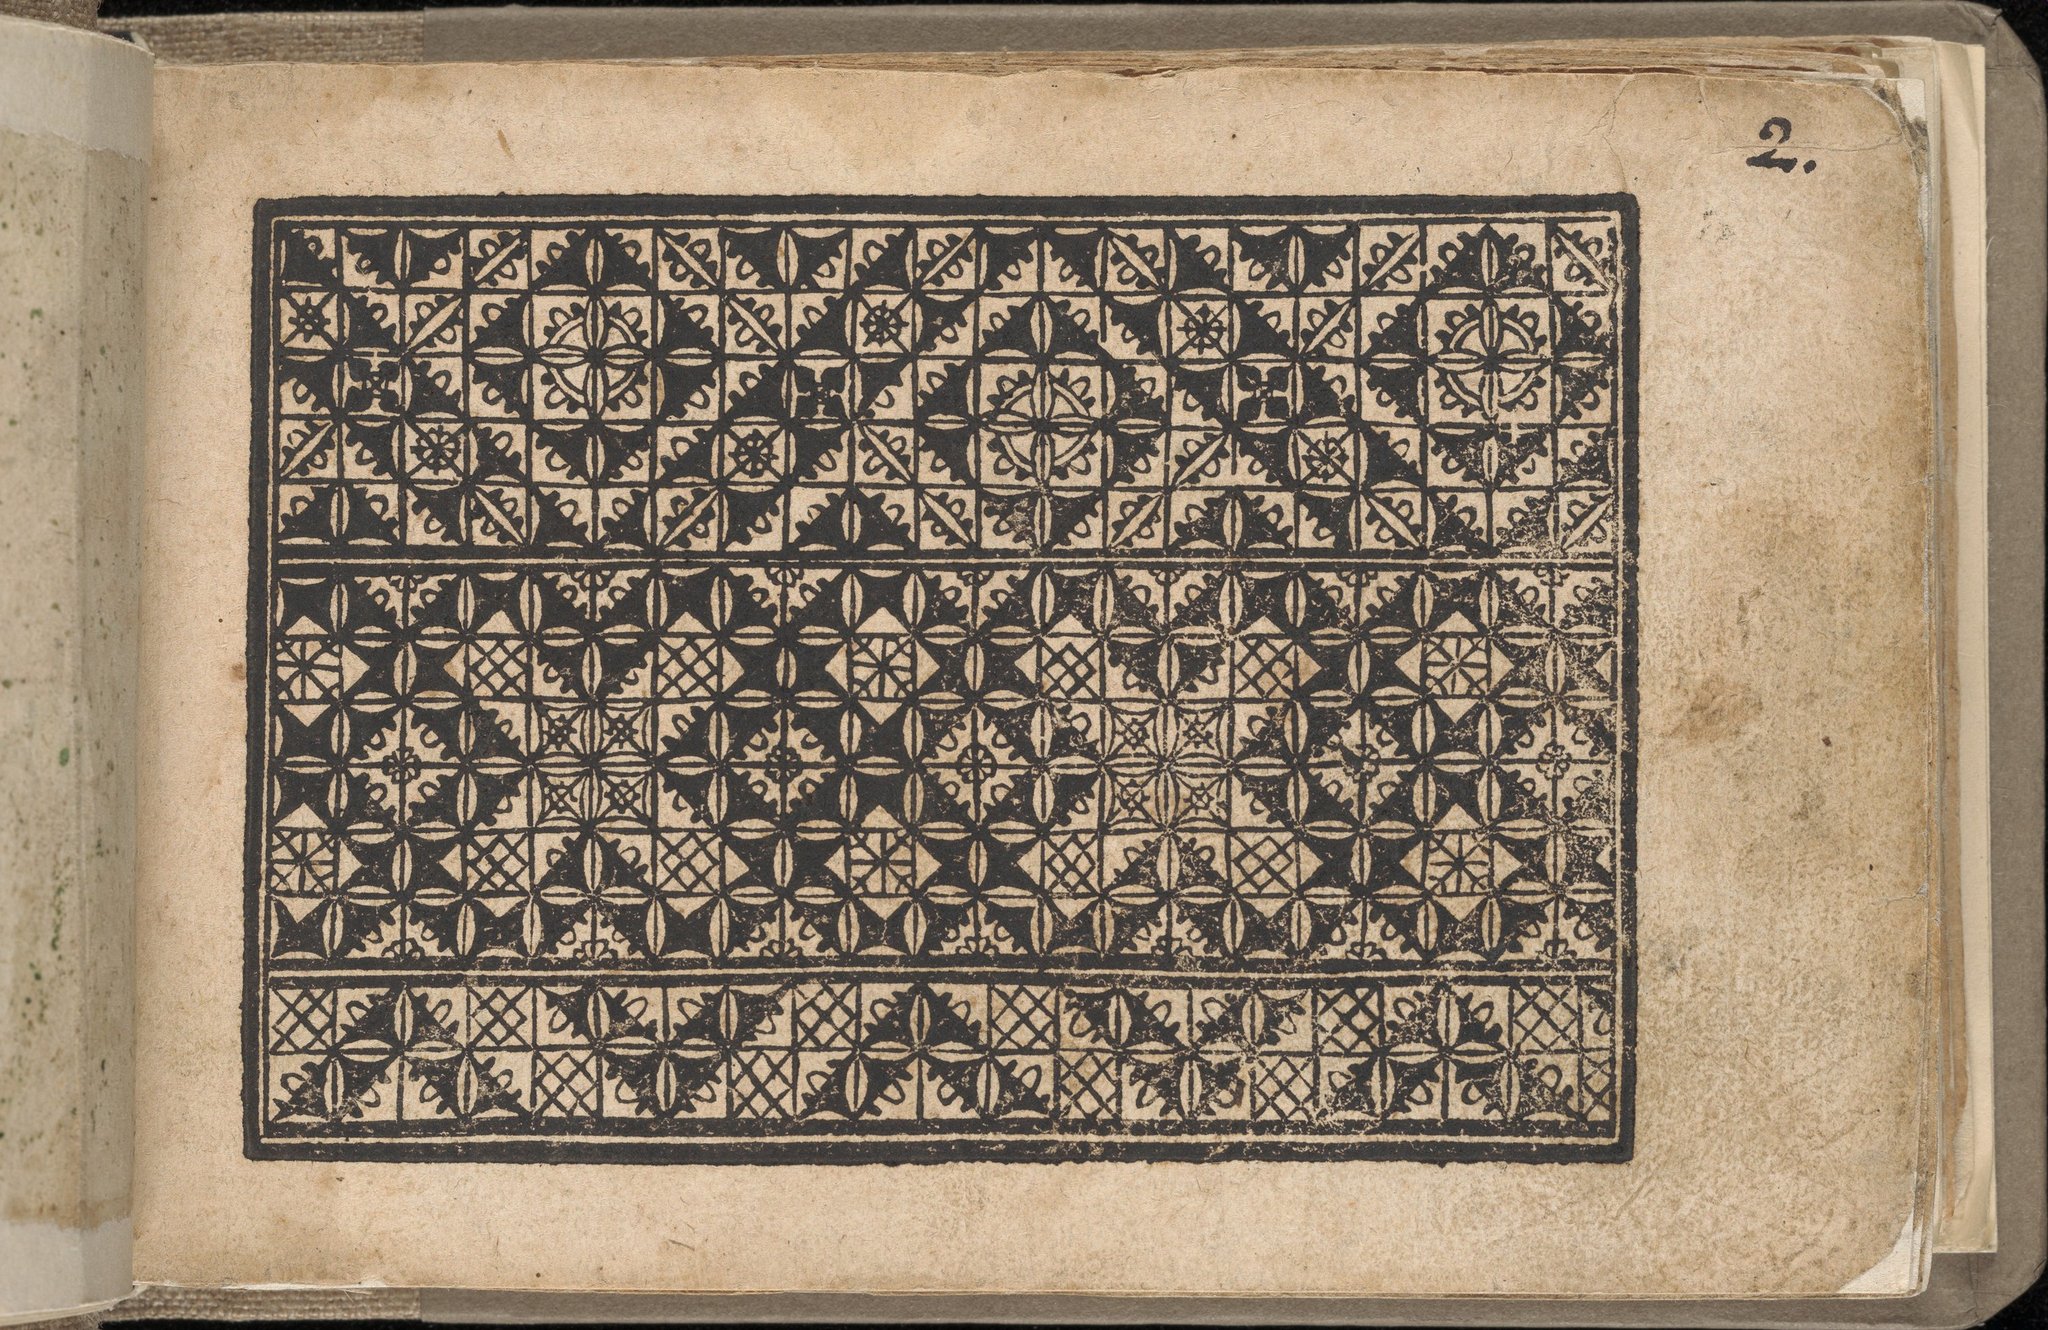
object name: book print ornament architecture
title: Schön newes Modelbuch (Page 2r)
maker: sigismundus latomus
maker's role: publisher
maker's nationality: german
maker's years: 1599-1632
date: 1608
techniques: woodcut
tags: ornament